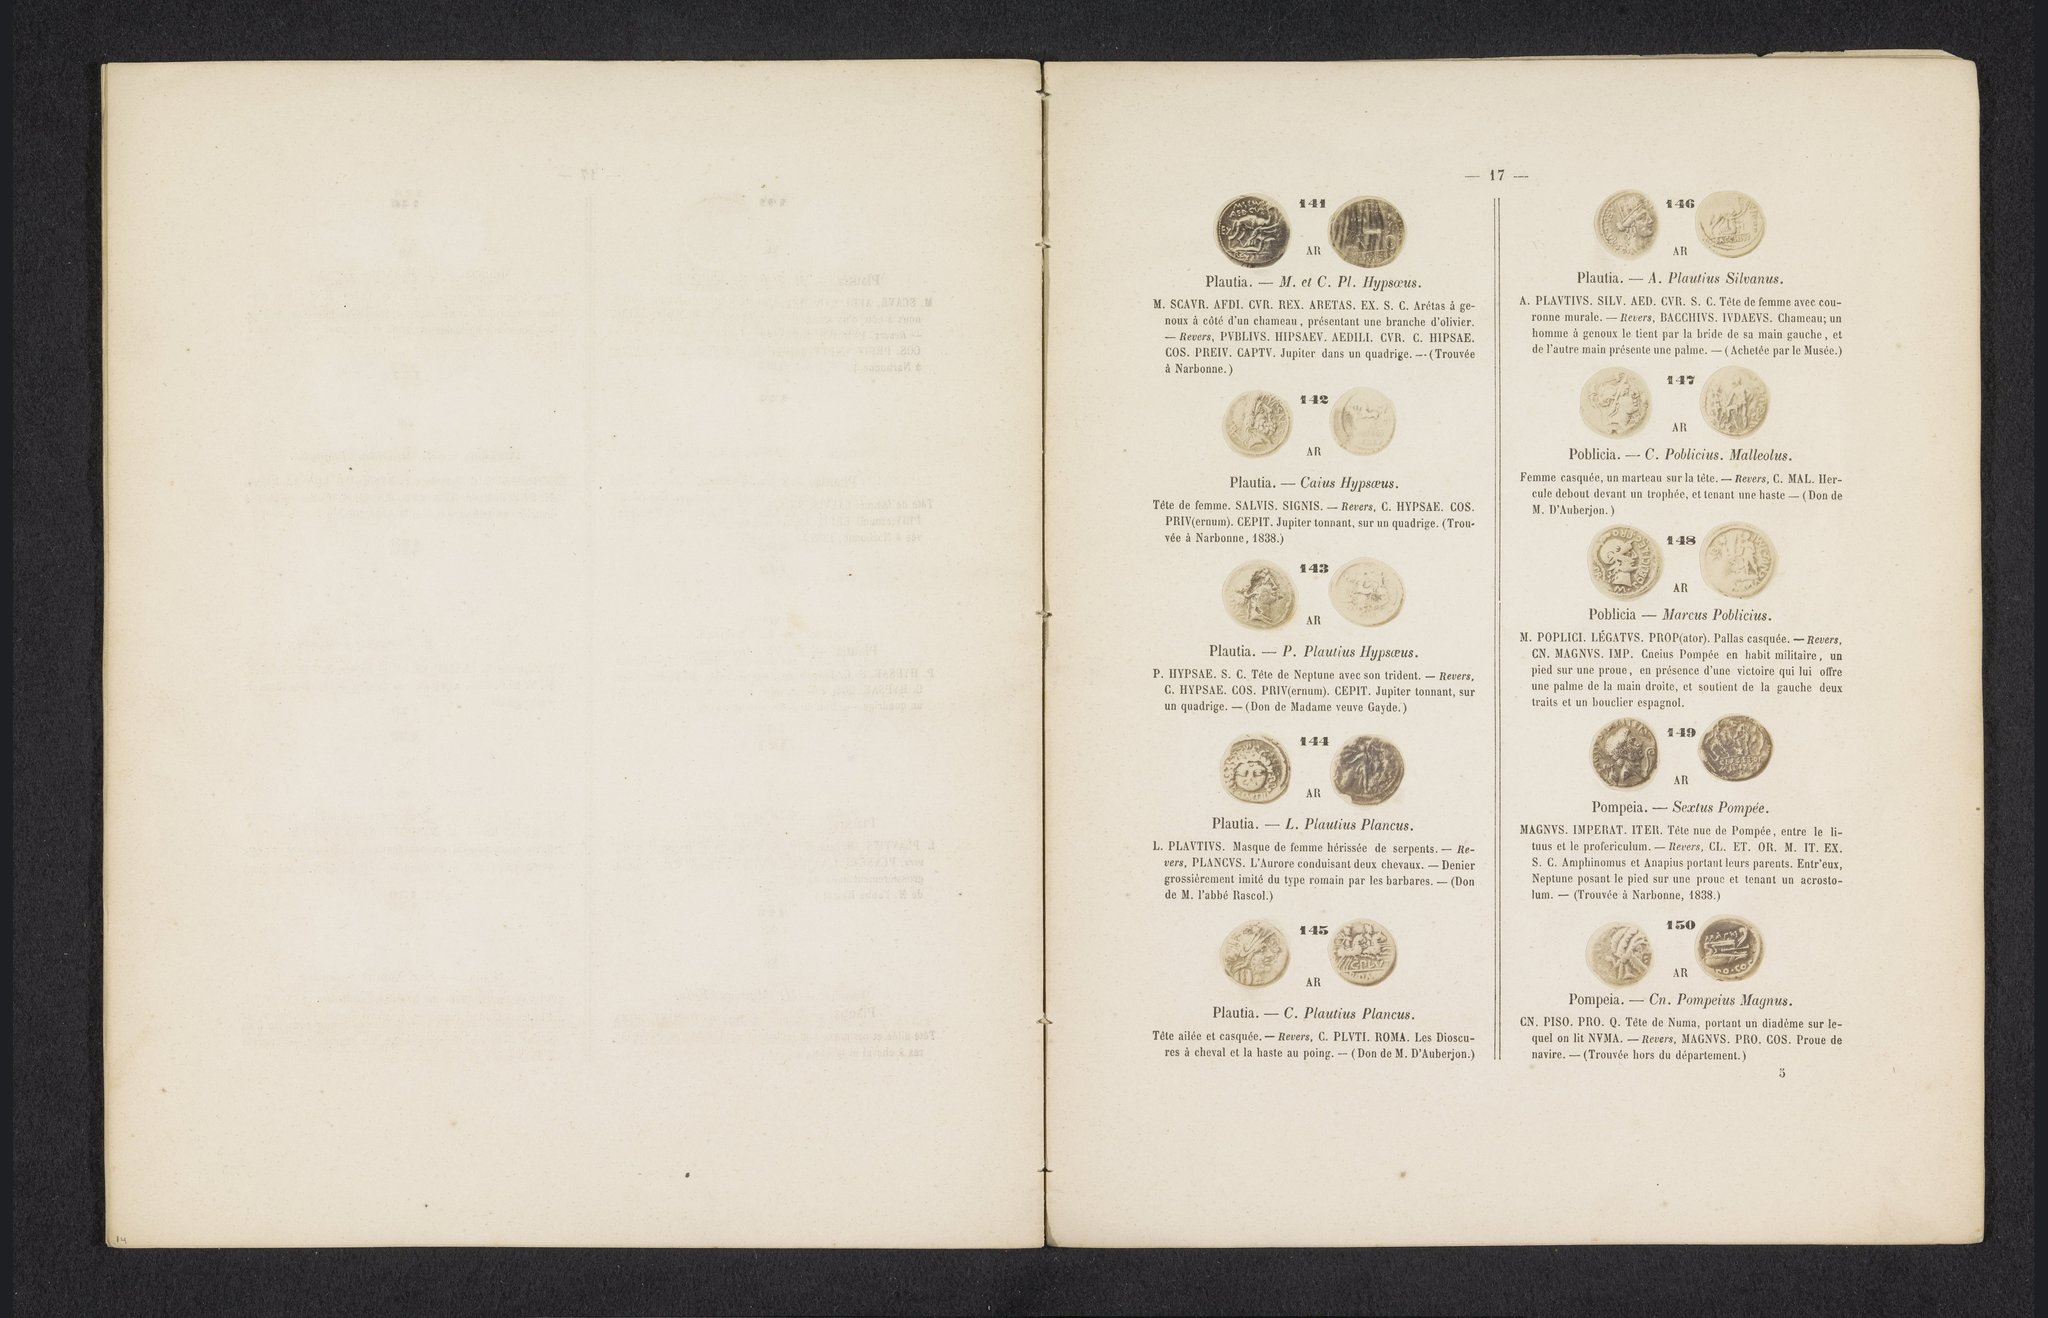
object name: photograph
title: Tien Romeinse munten, gezien van voor- en achterkant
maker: léopold verguet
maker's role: abt, fotograaf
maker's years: 1817-1914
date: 1854-1864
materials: photographic support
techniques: albumen print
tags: coin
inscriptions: number